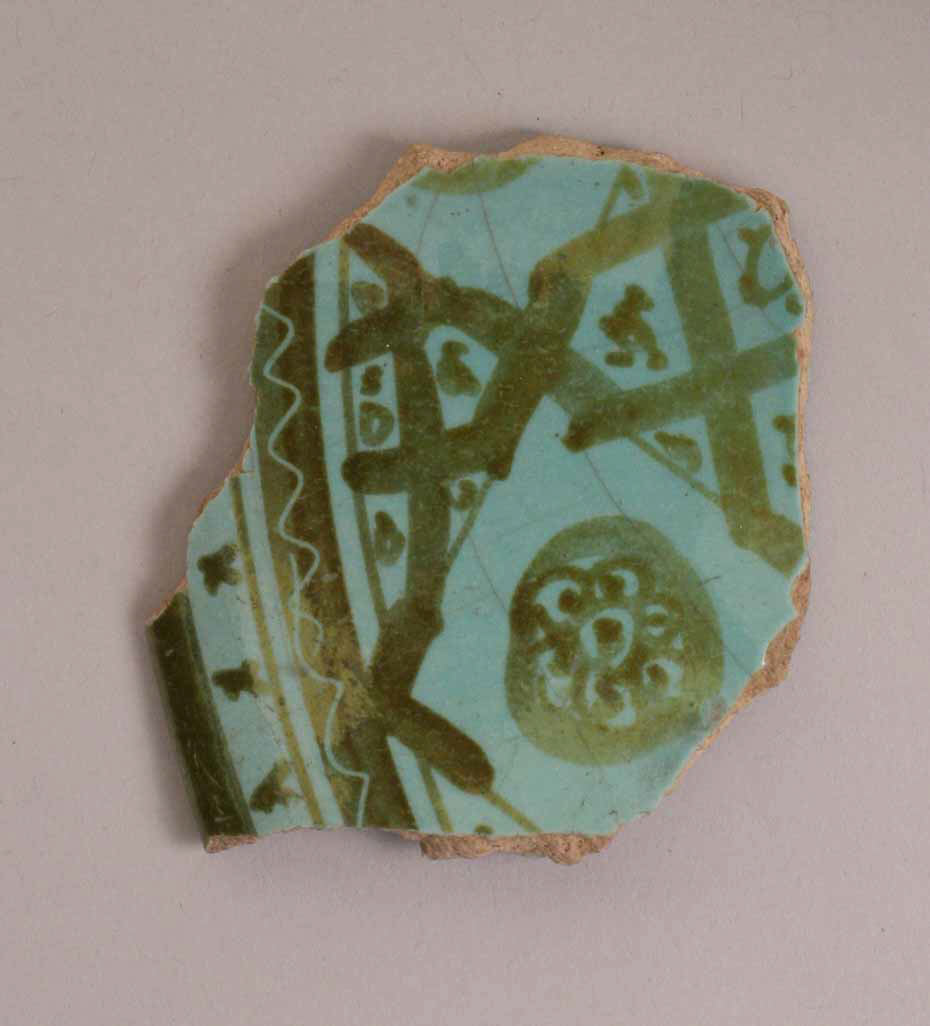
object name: ceramic fragment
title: Fragment of Dish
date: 1001-1200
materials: earthenware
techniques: glazing, luster painting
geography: syria